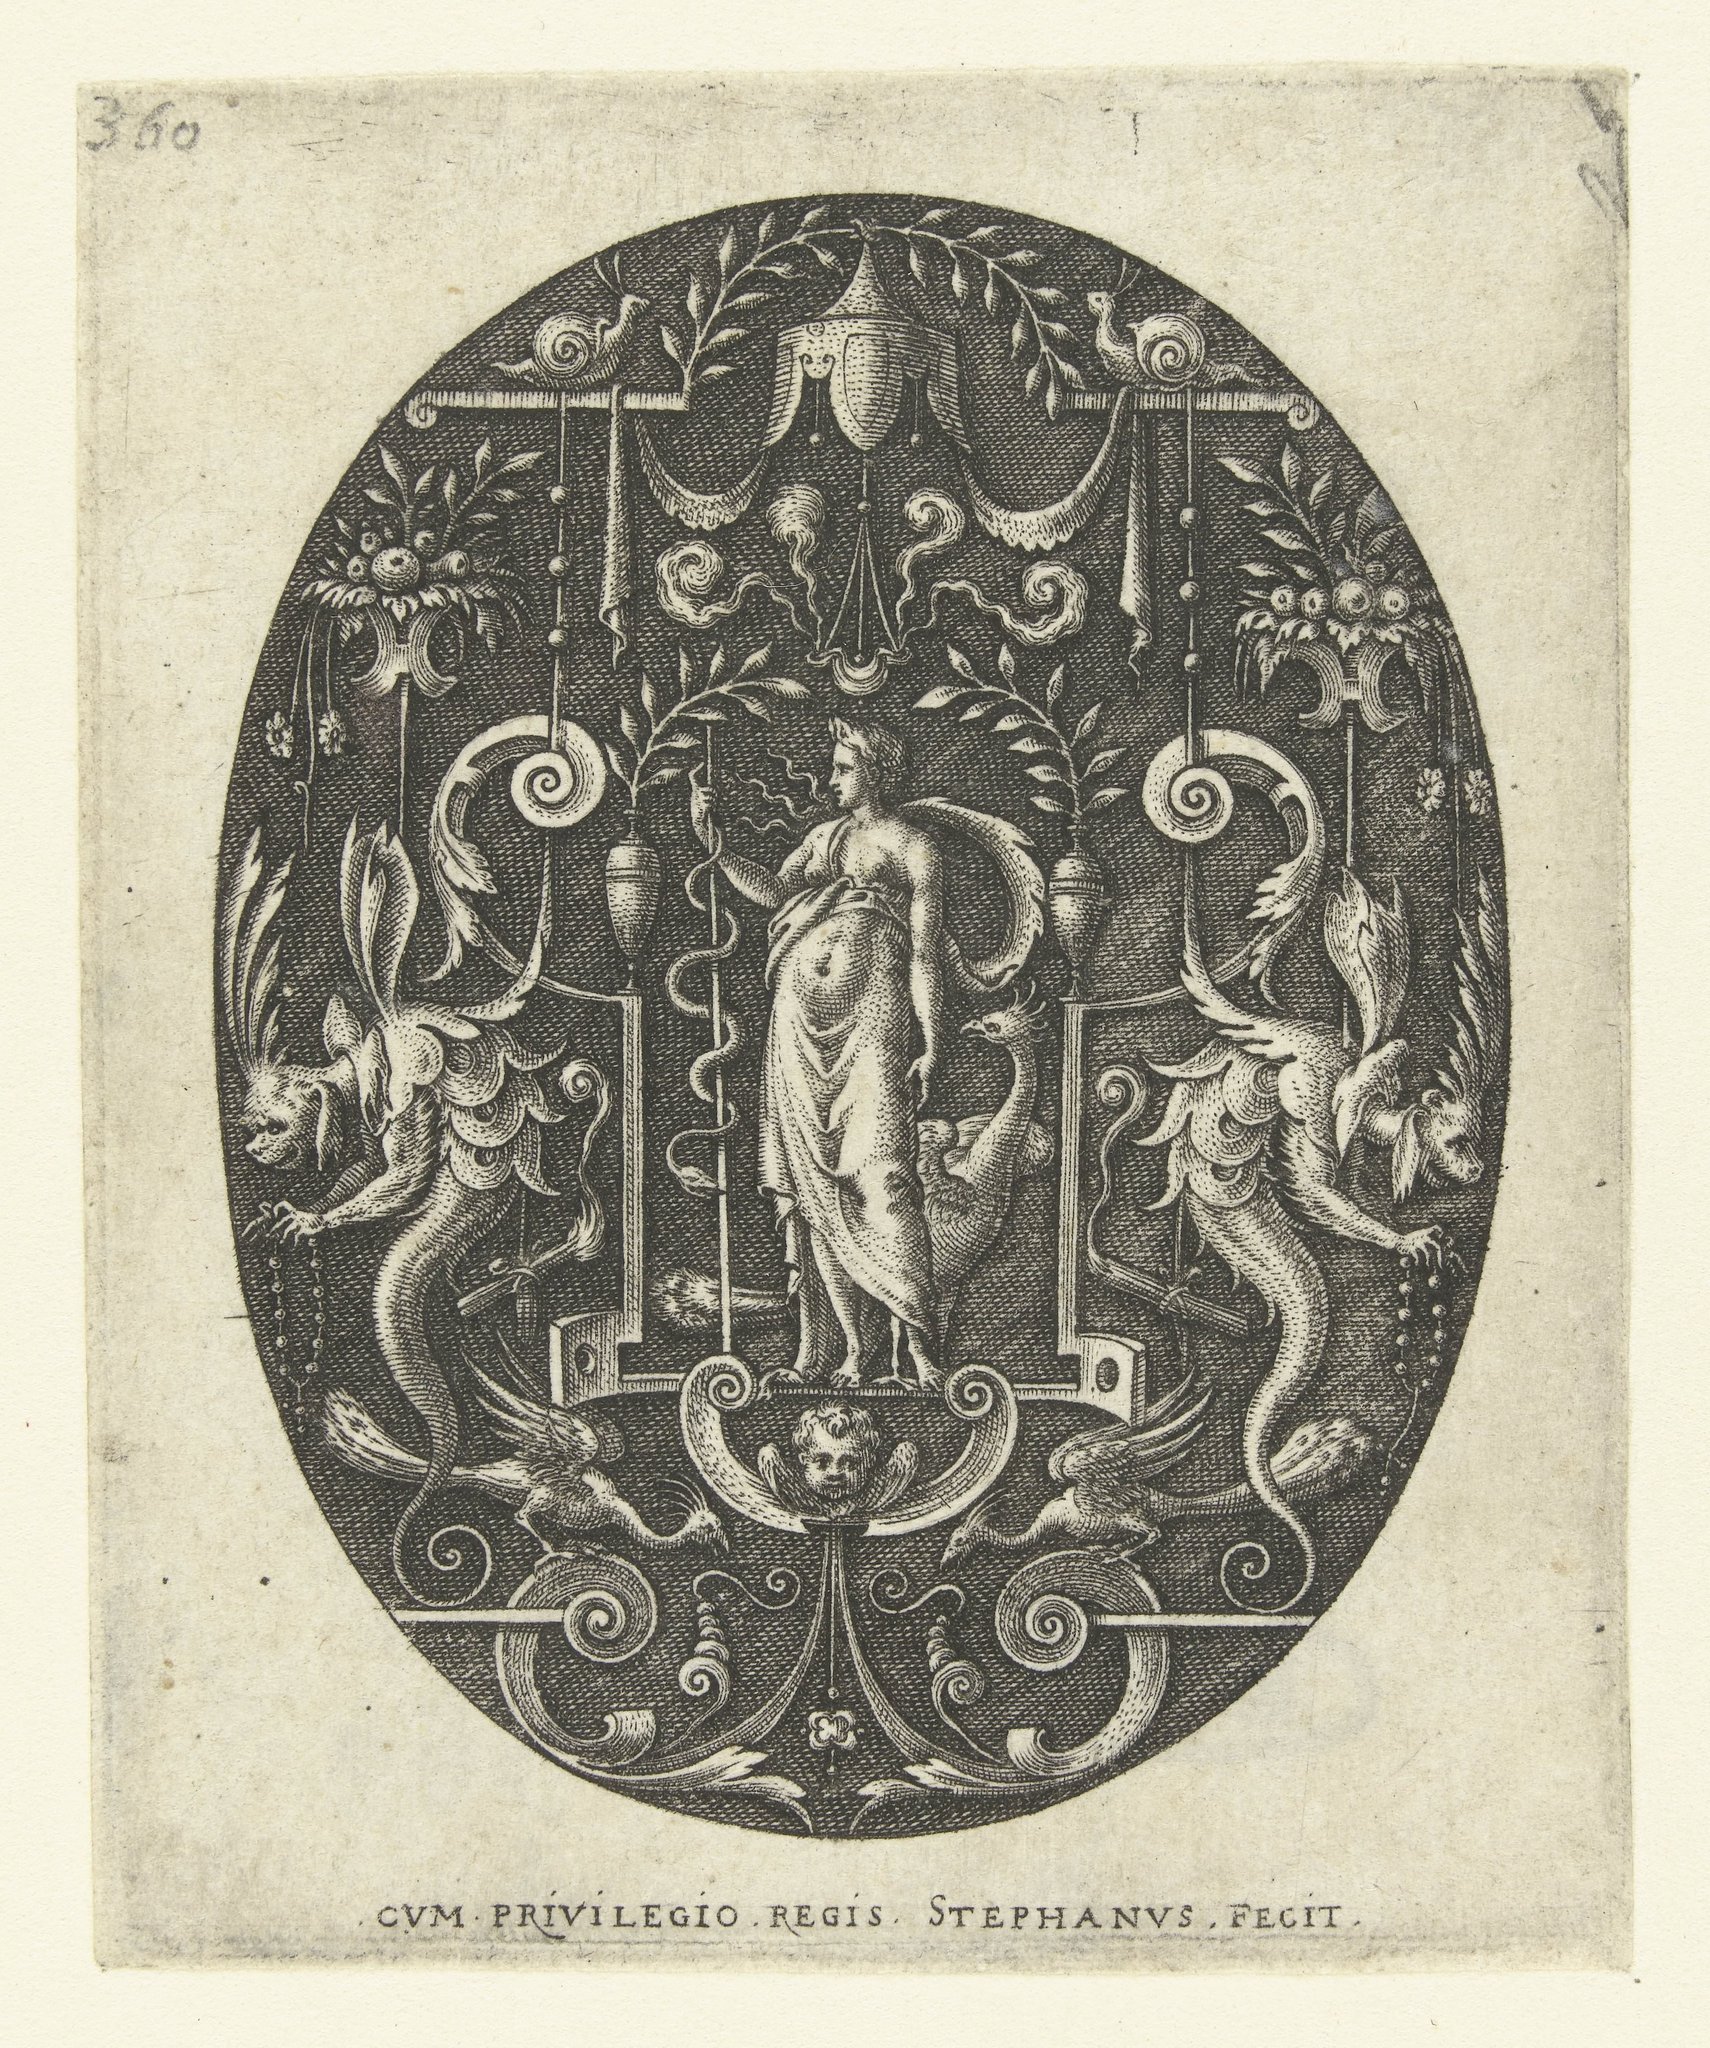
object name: ornament print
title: Juno met pauw aan haar voeten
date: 1528-1583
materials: paper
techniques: engraving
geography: france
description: Juno staat tussen twee fantastische wezens met geschubde lichamen en een hondenkop. Uit serie van 6 bladen.